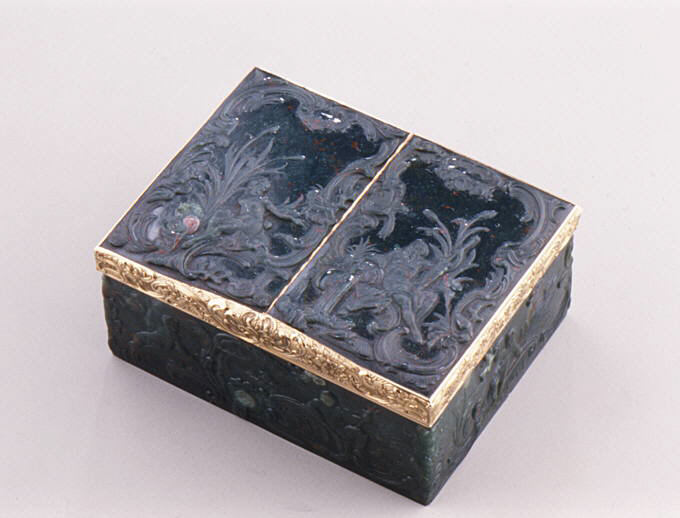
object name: snuffbox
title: Double snuffbox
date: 1750-1760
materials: gold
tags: human figures